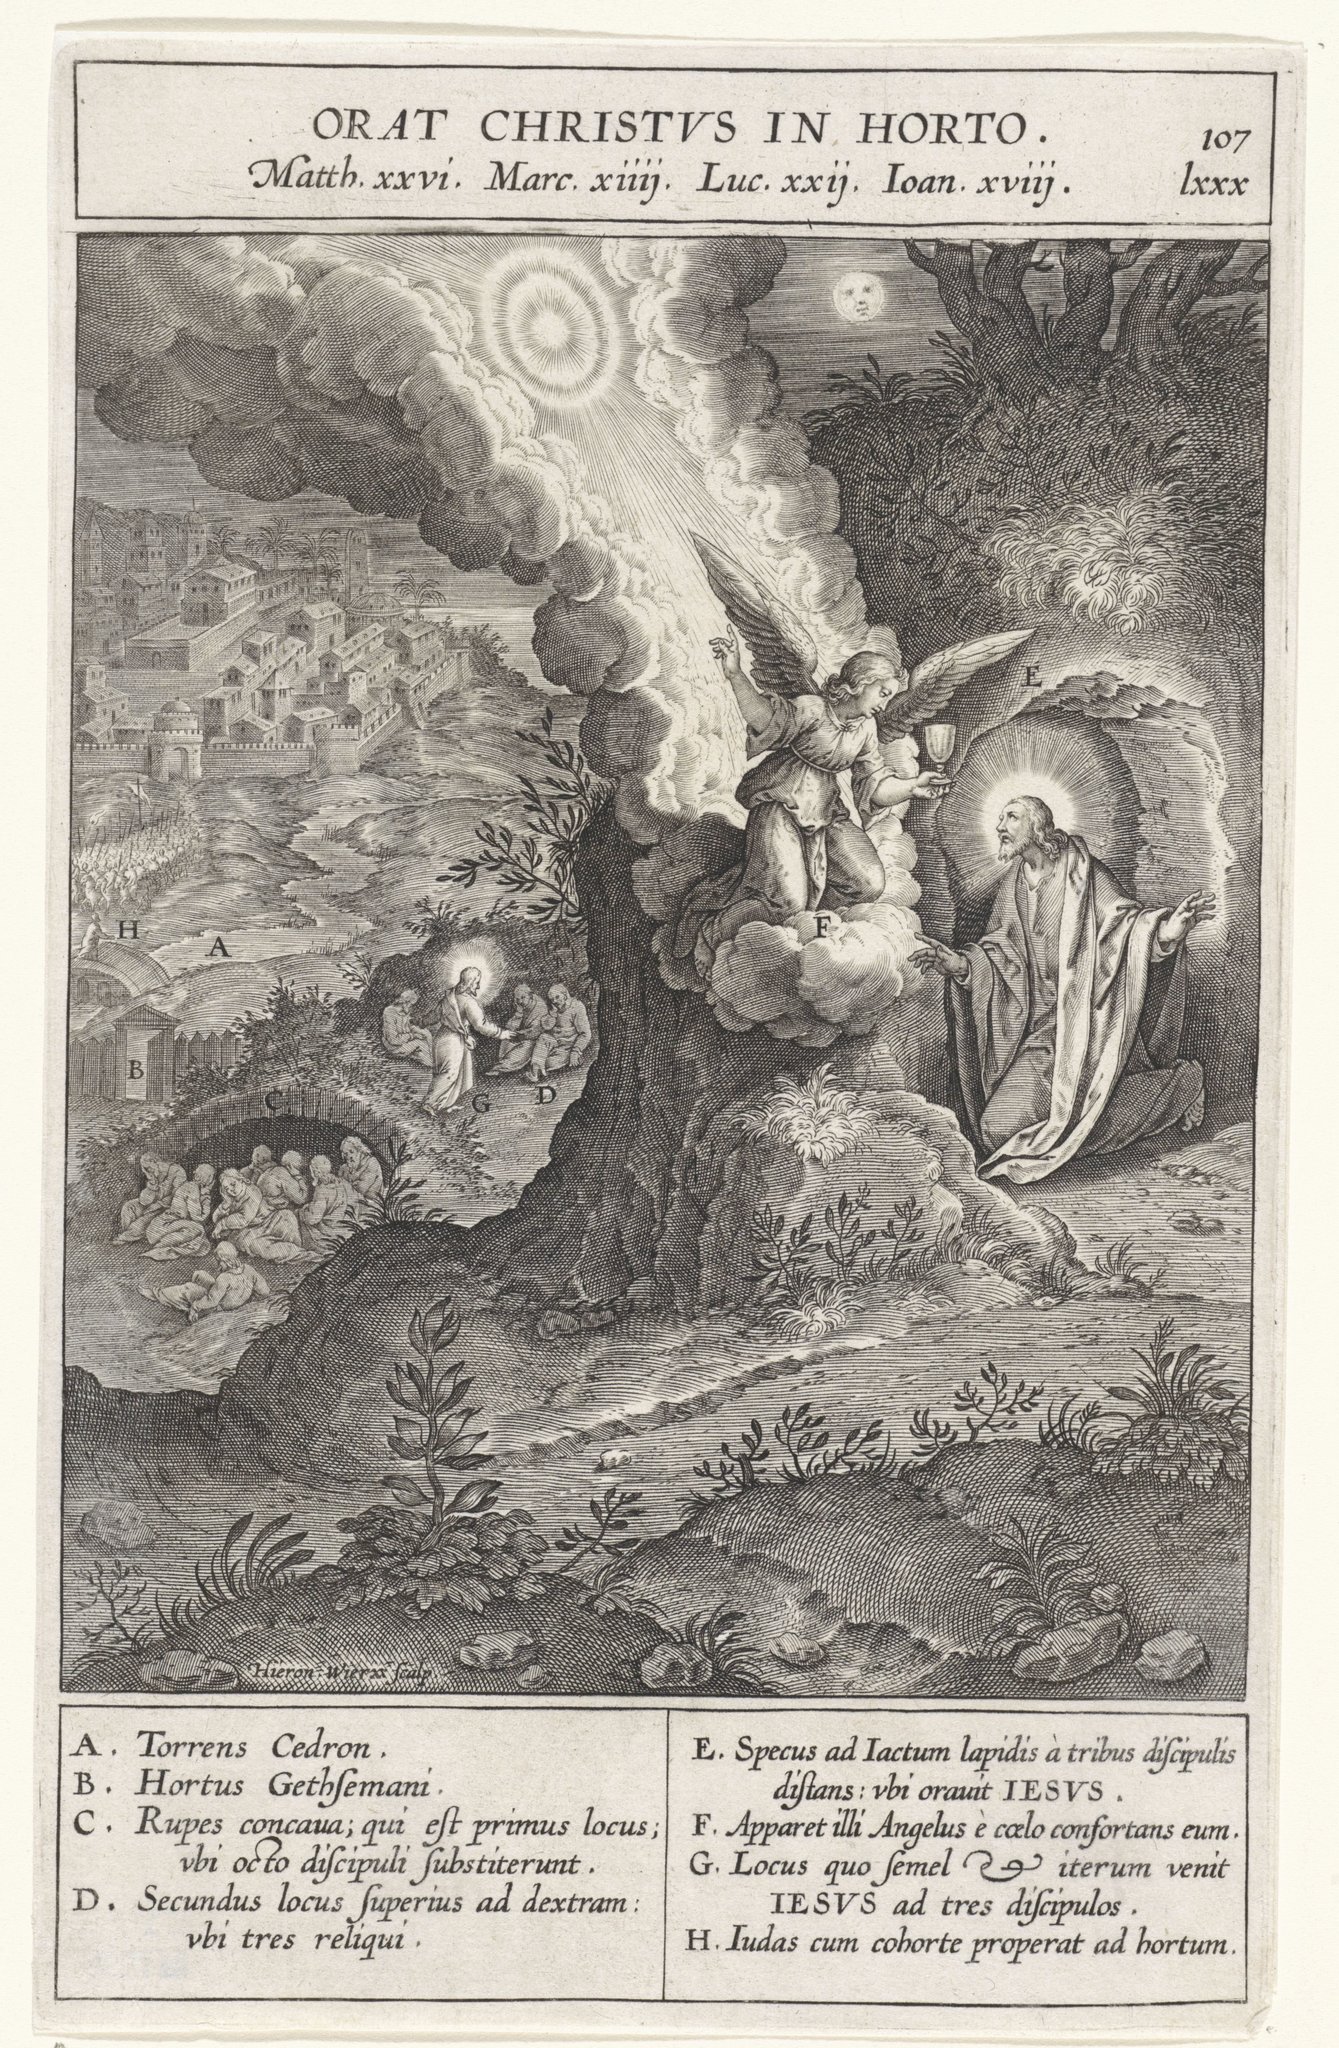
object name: print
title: Orat Christvs in Horto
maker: hieronymus wierix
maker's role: draughtsman, print maker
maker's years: 1553-1619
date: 1593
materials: paper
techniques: engraving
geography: antwerp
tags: christ's prayer in the garden of gethsemane during the night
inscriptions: collector's mark: Lugt 2165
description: Christus bidt in de hof van Getsemane. Uit de hemel verschijnt een engel met een kelk. Zijn leerlingen liggen te slapen op de achtergrond. Judas komt de tuin binnen door de poort en wijst de soldaten de plek waar Christus bidt. Bij verschillende elementen uit de voorstelling staan letters die corresponderen met de legenda in de marge.